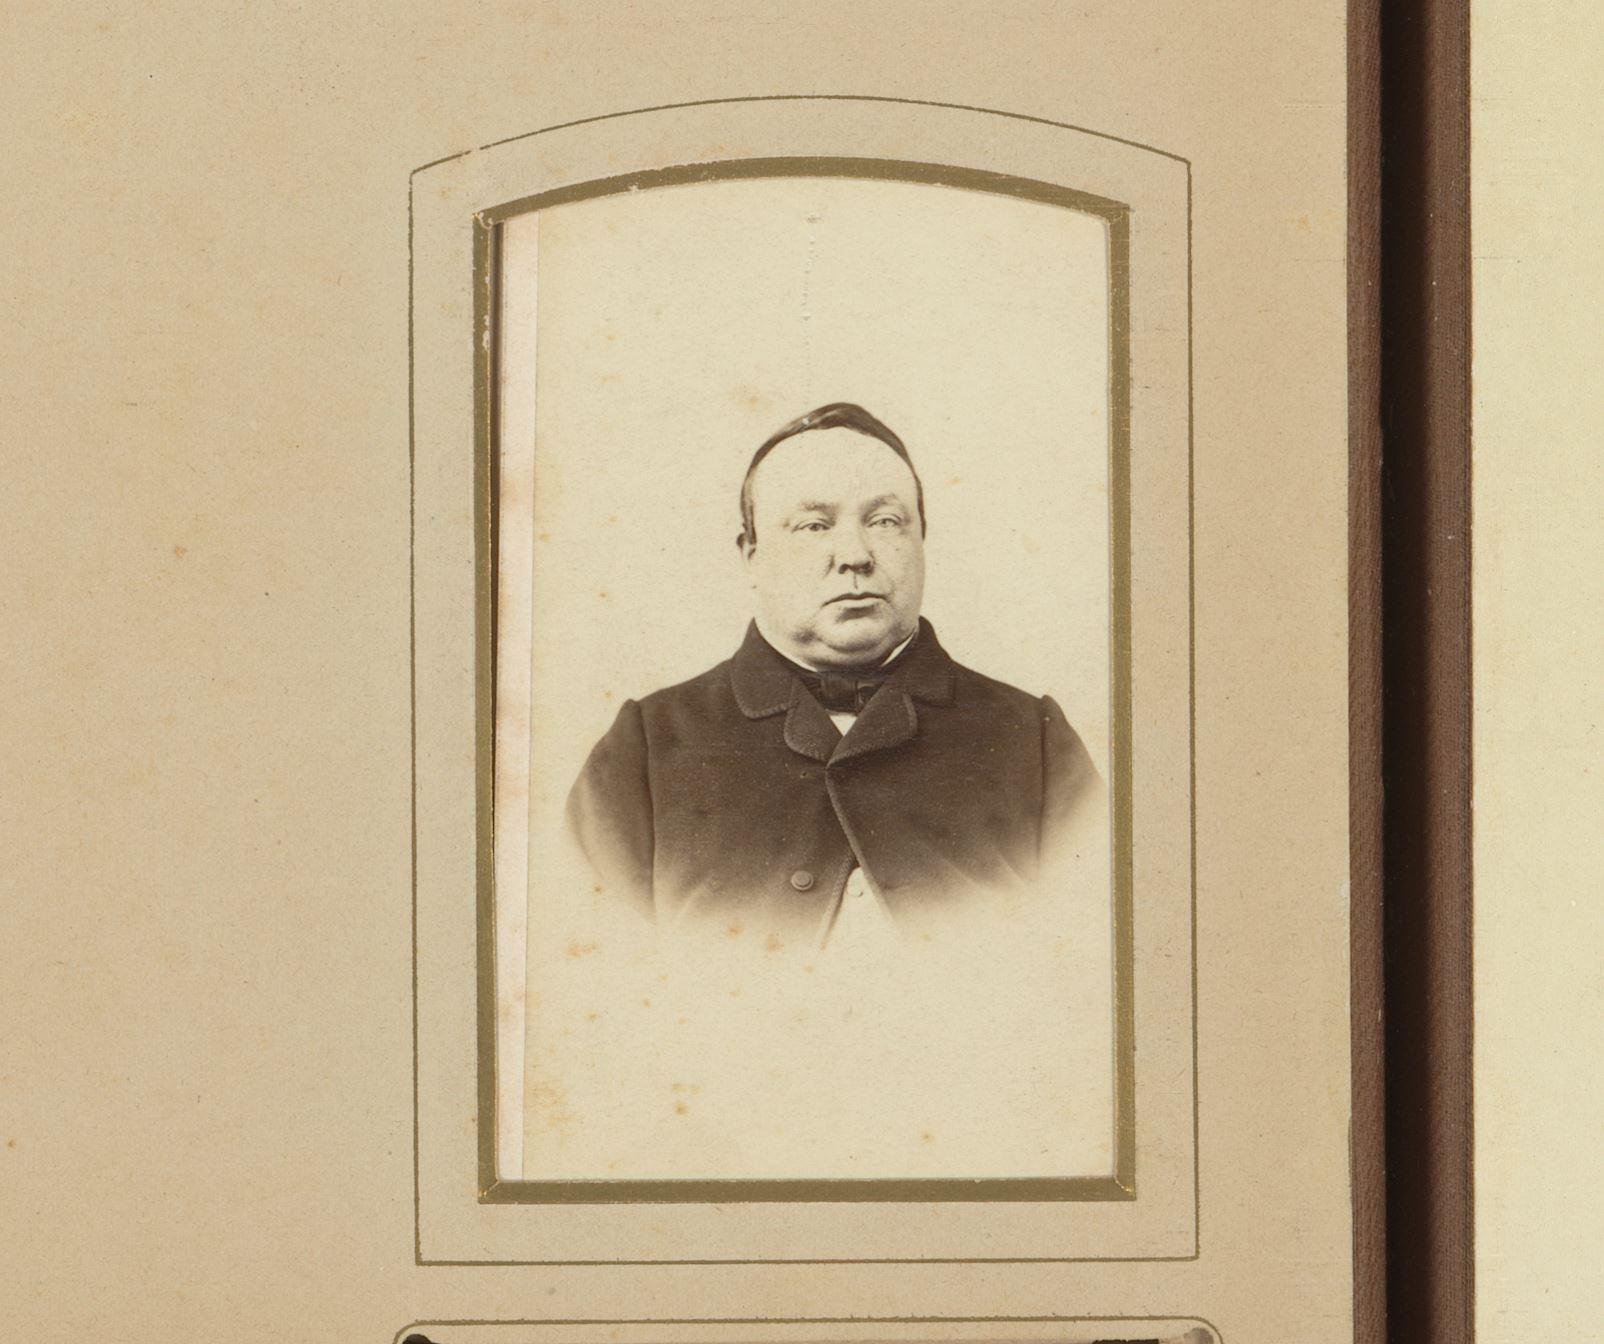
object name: photograph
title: Portret van een man met vlinderstrik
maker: césar mitkiewicz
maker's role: fotograaf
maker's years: 1836-1871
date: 1863-1867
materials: cardboard, photographic support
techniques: albumen print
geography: brussels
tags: historical persons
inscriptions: inscription: ‘CESAR MITKIEWICZ & Cie/ PHOTOGRAPHES/ 9, Rue Neuve, 9./ BRUXELLES’